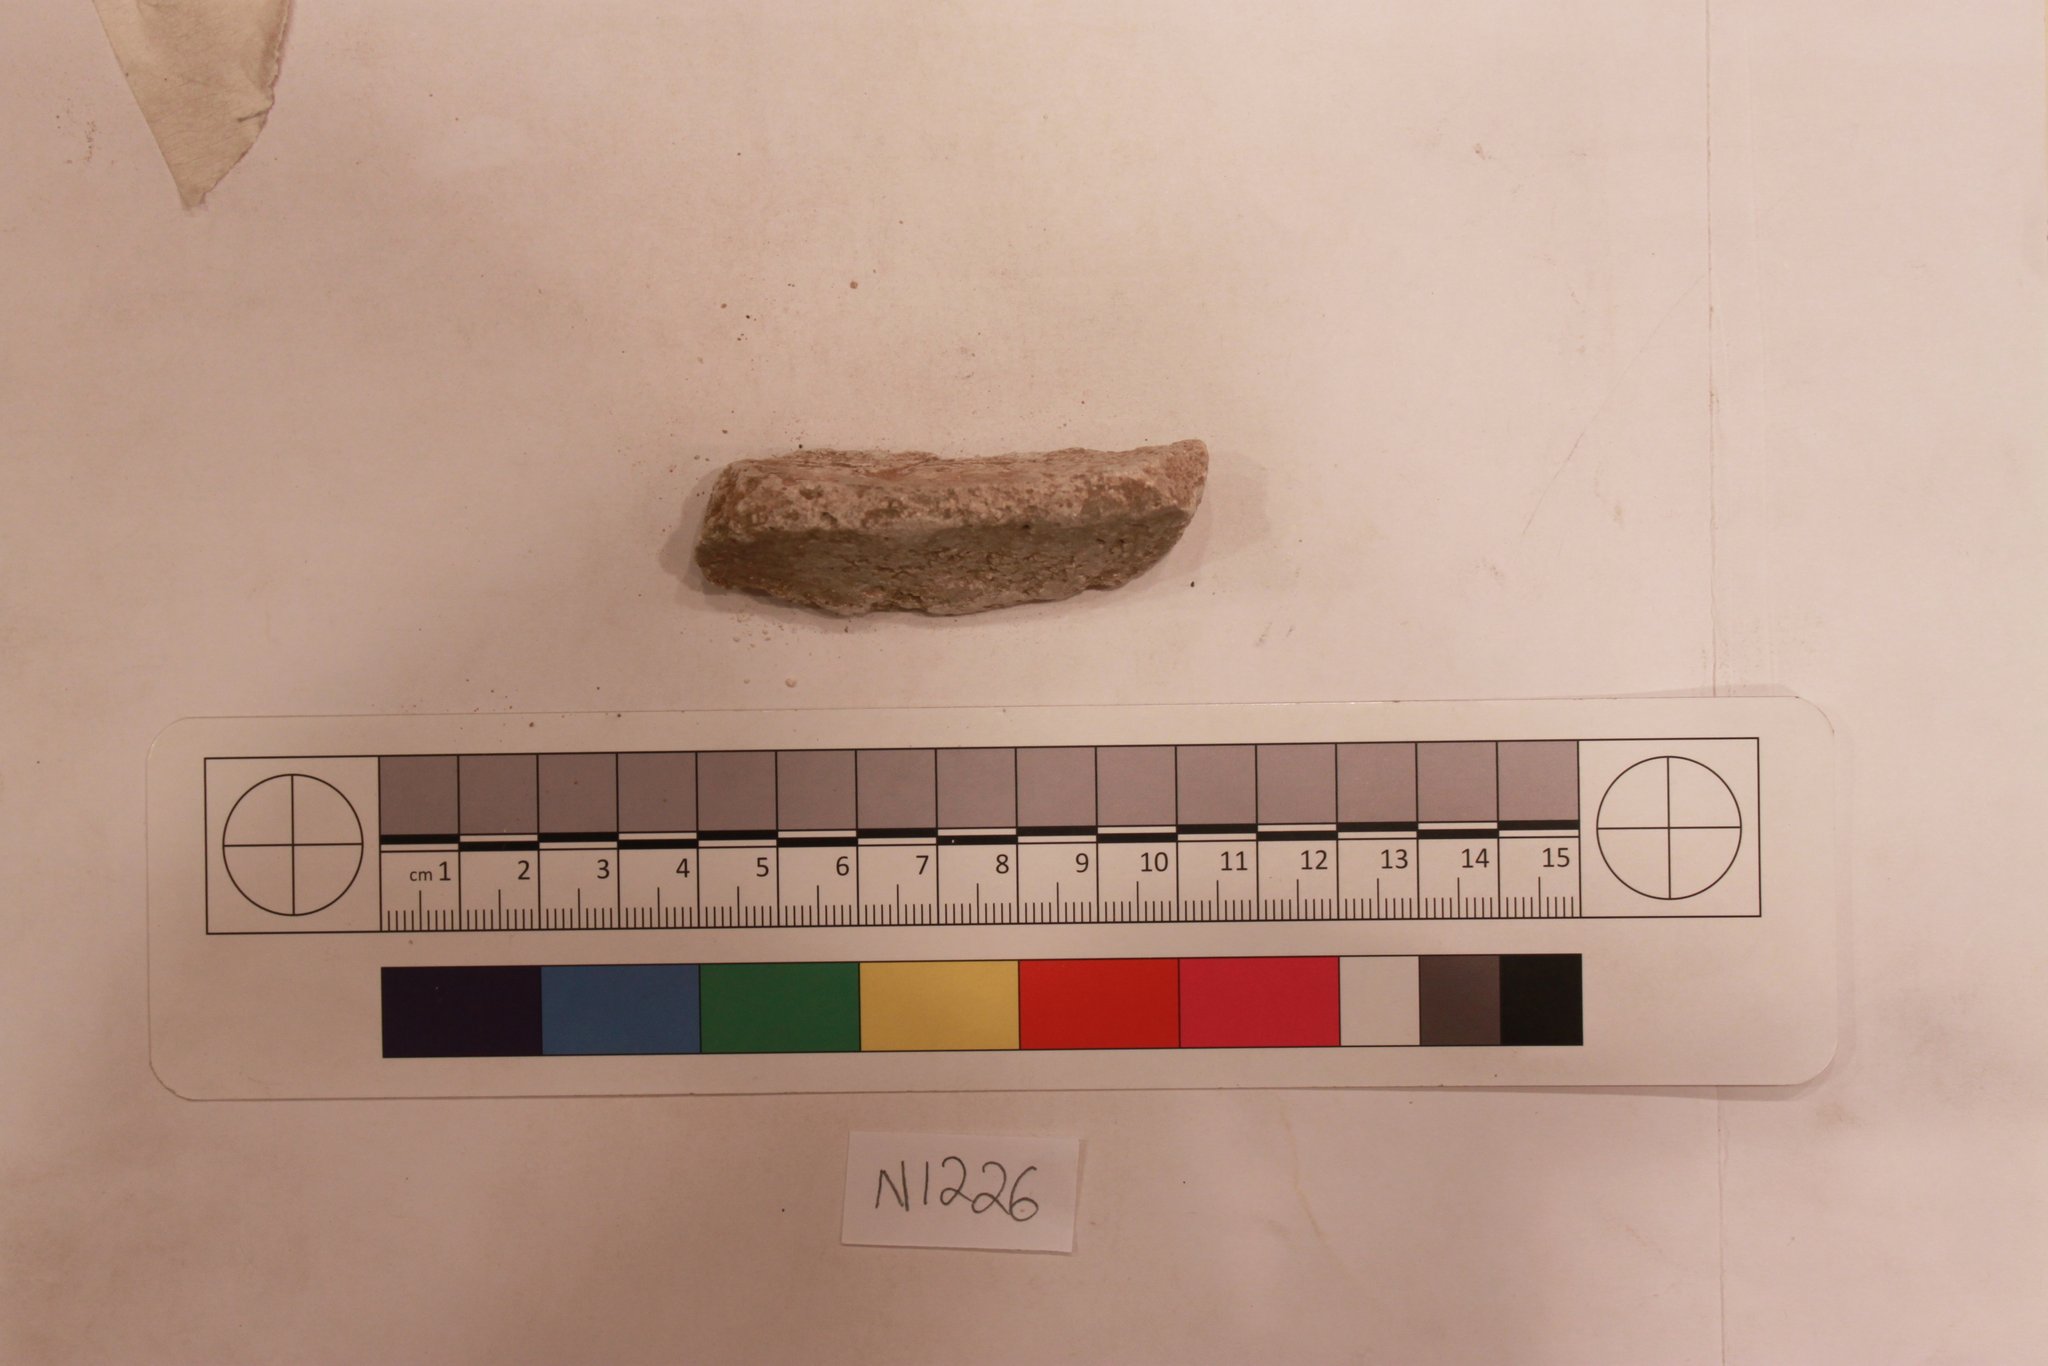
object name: fragment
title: Stucco Fragment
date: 701-1200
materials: plaster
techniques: carving, painting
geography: iran